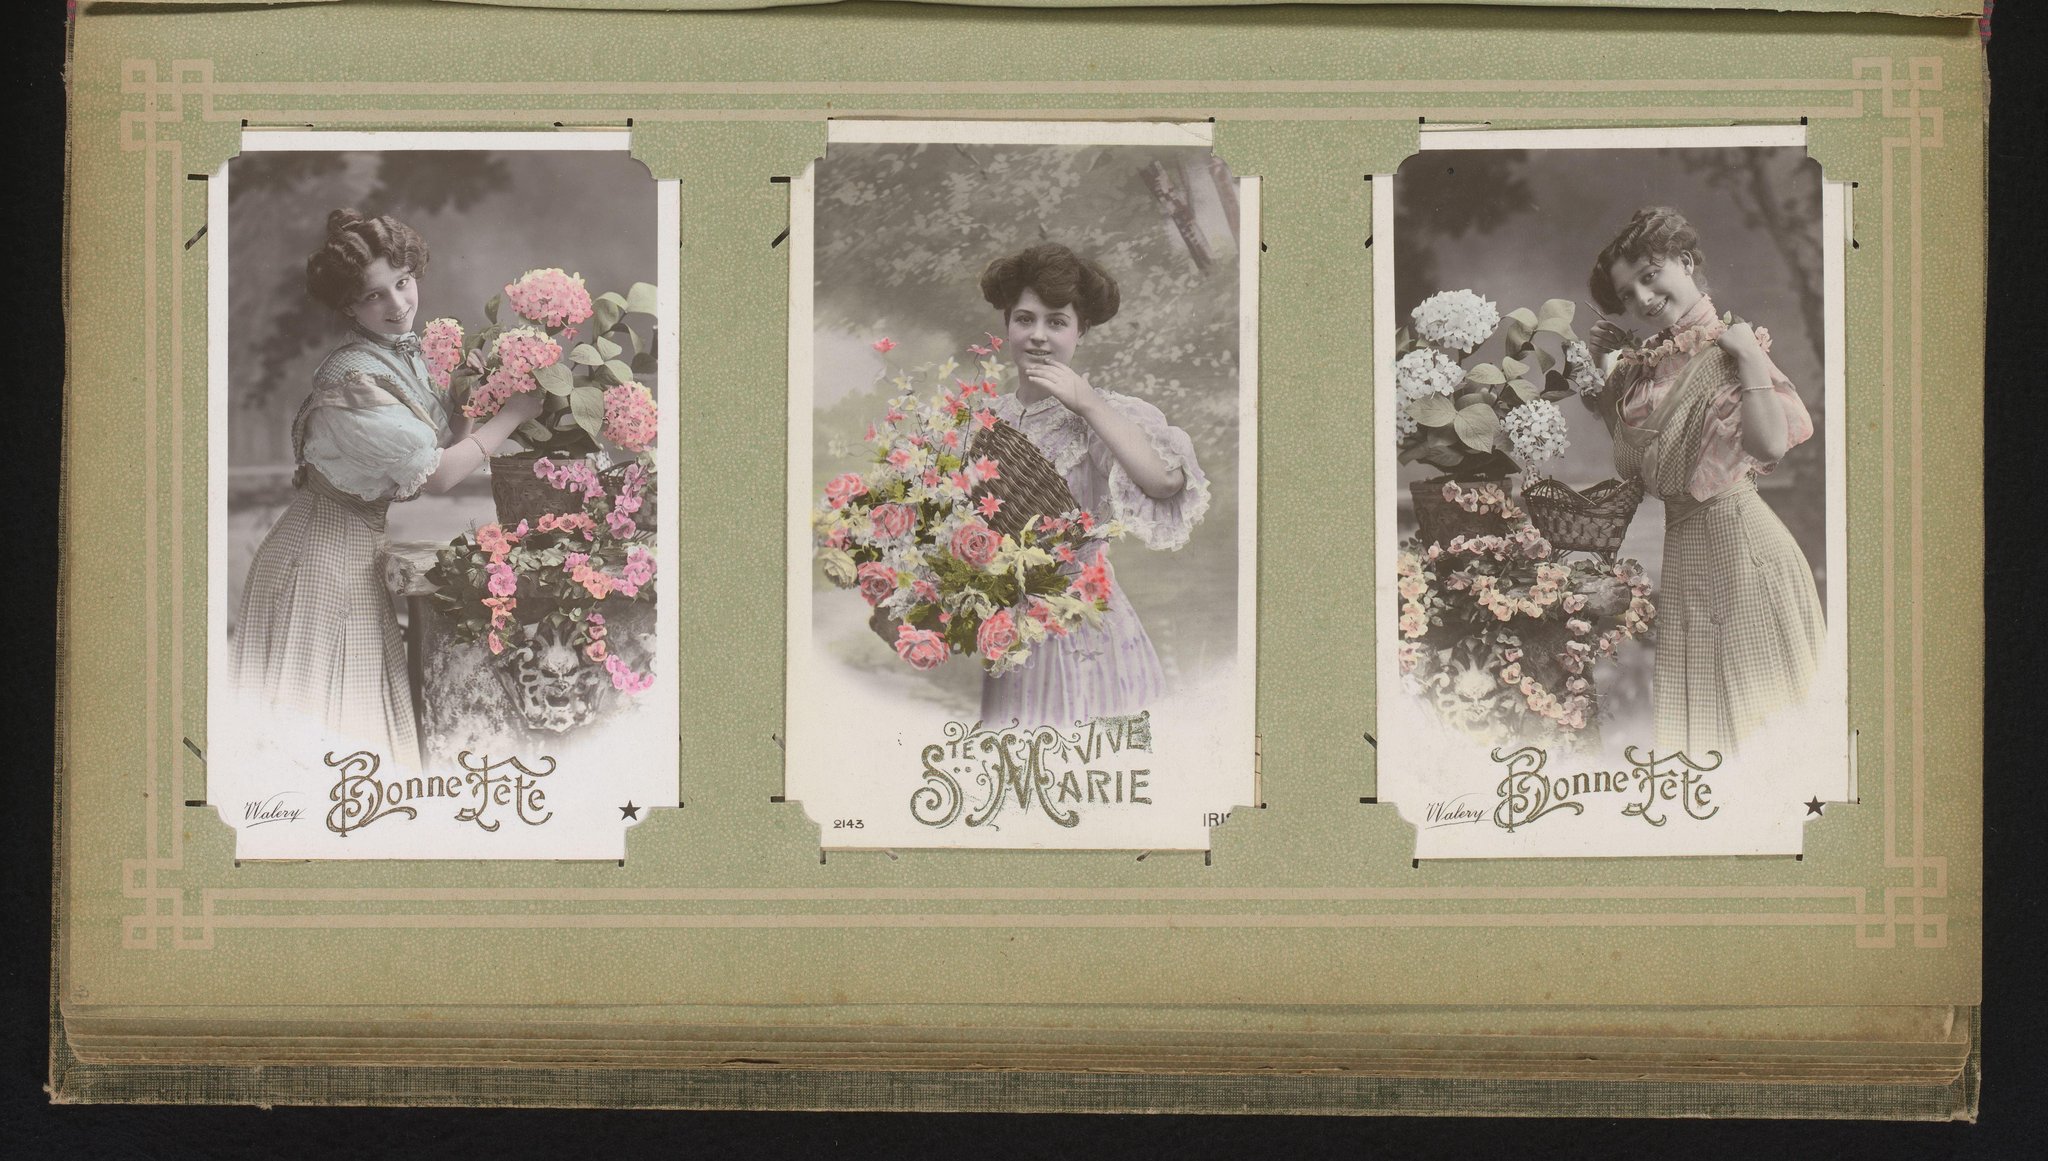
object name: ansichtkaart, prentbriefkaart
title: Drie portretten van vrouwen met bloemen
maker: walery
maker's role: fotograaf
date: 1900-1930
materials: cardboard, photographic support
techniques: gelatin silver print, hand coloring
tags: flowers, historical persons - bb - woman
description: Deze foto's maken deel uit van een album.